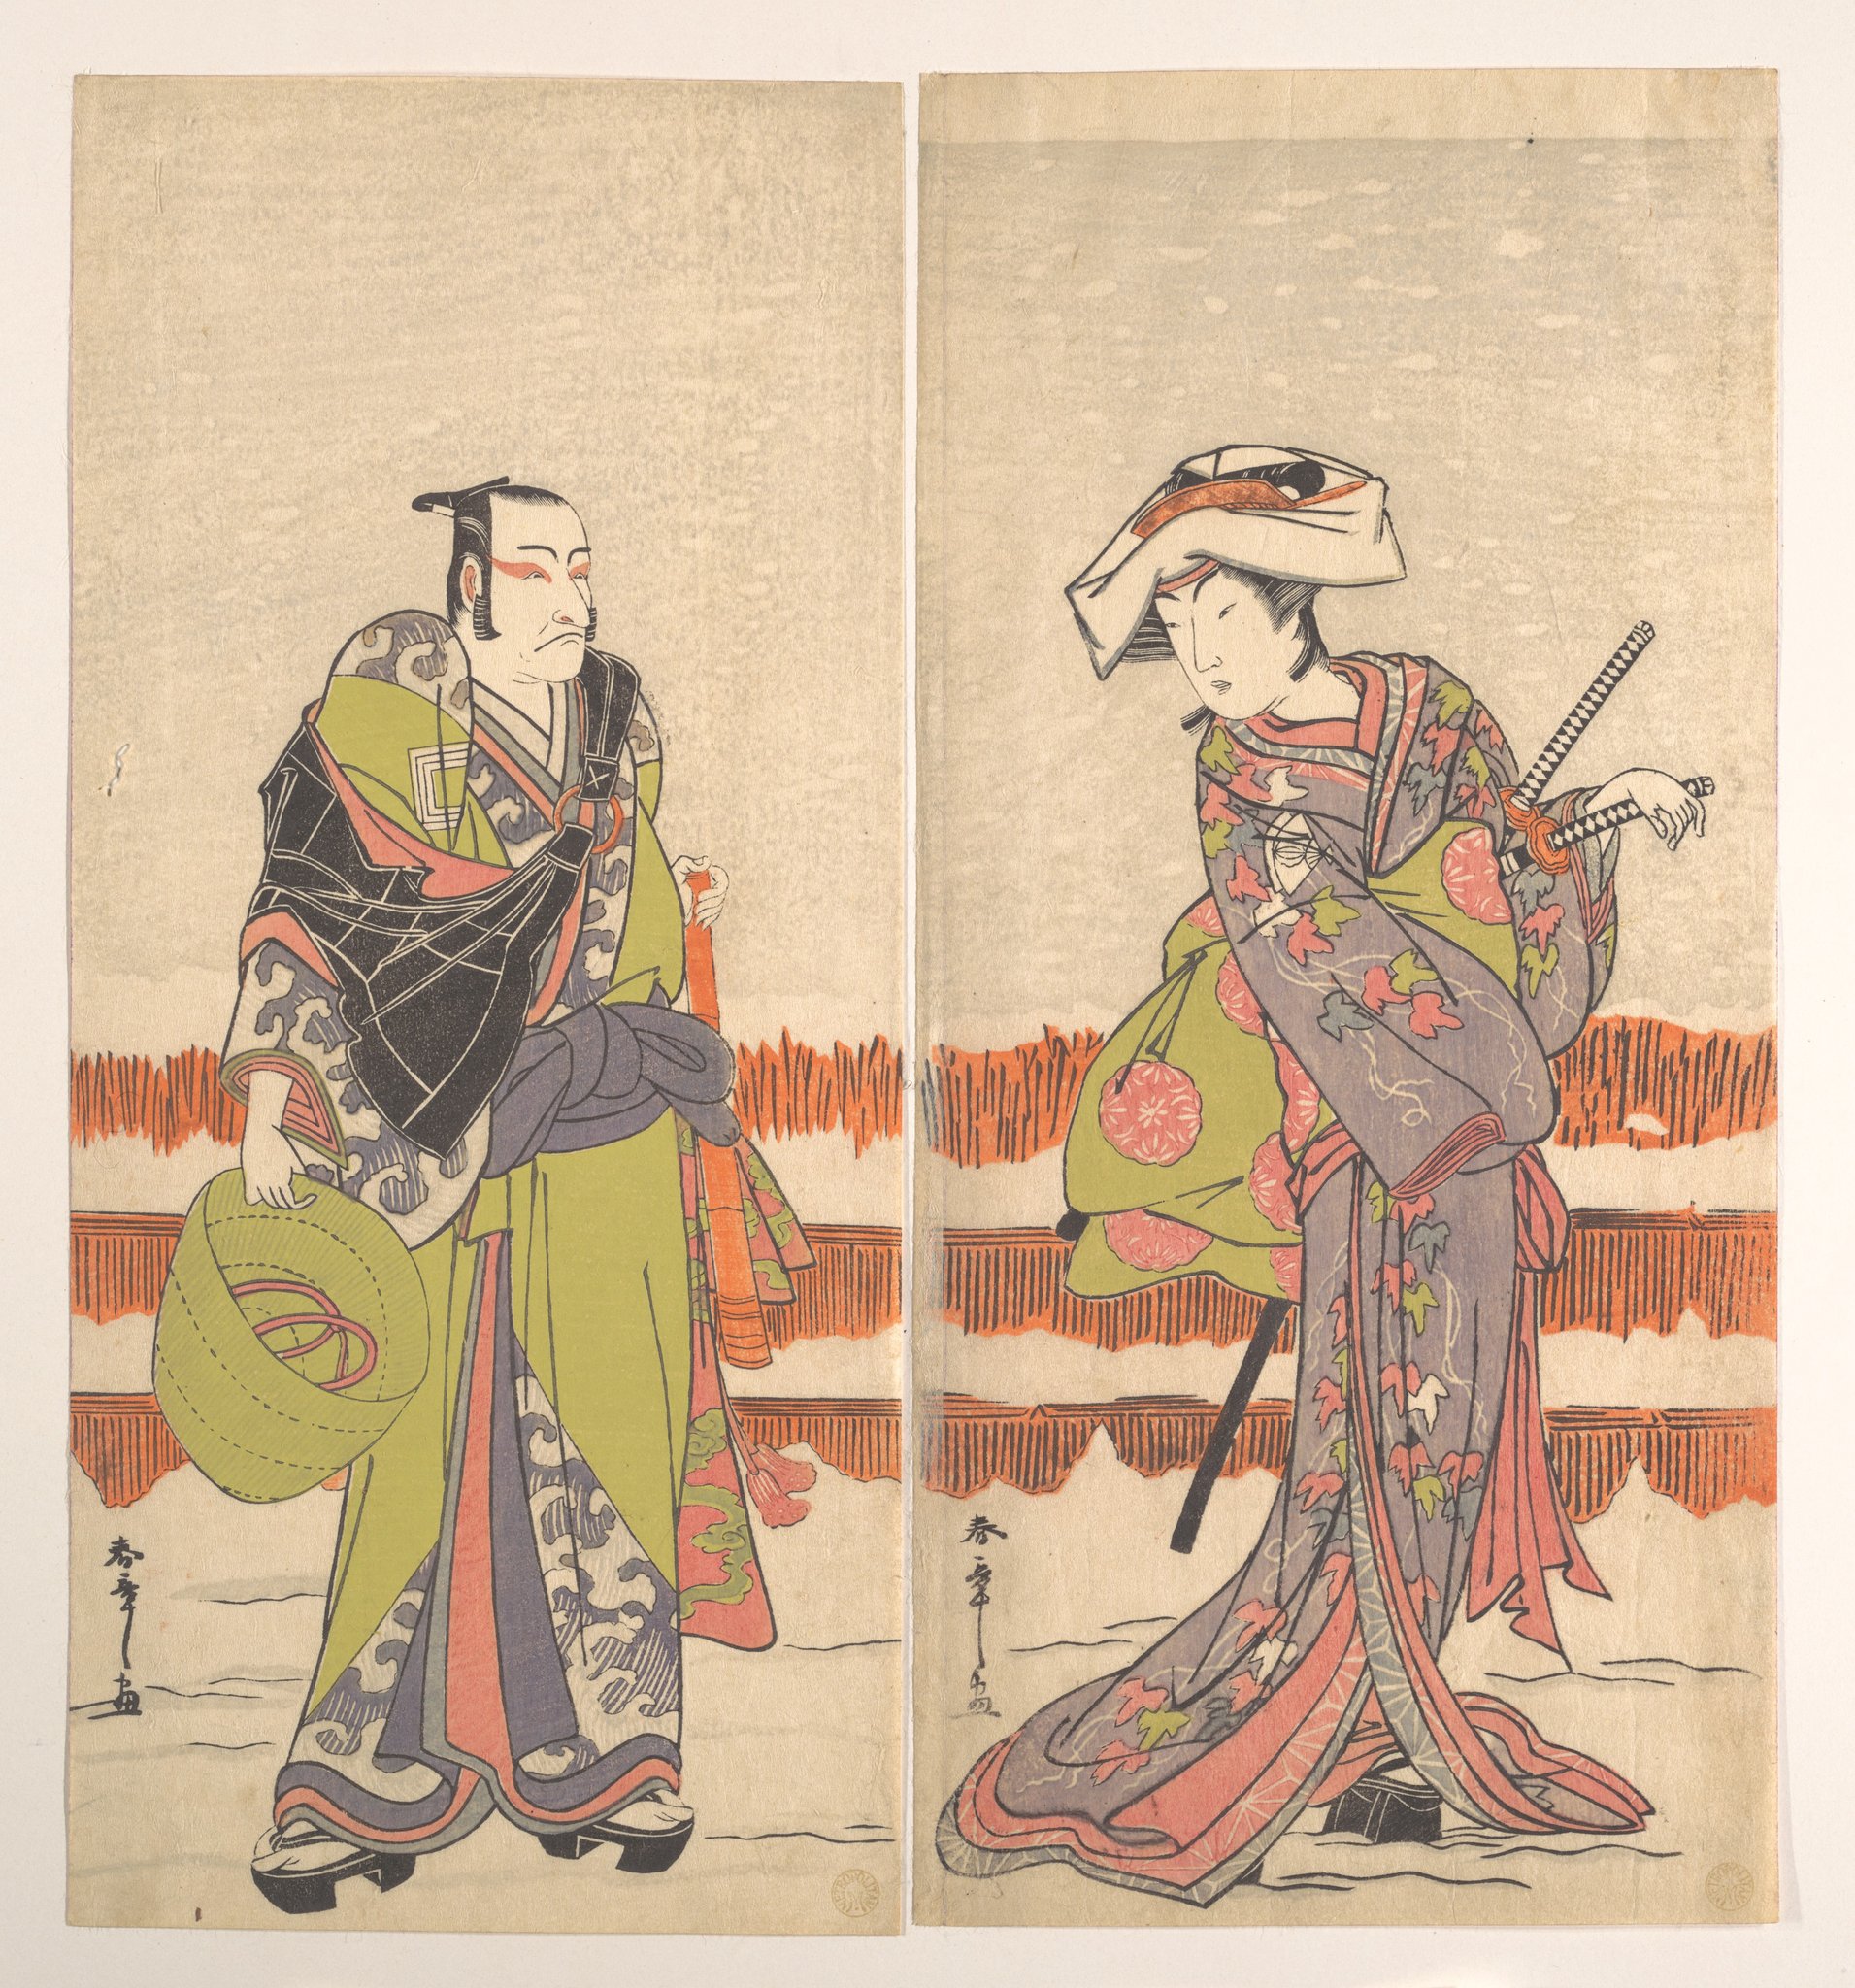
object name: woodblock print nishiki e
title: Ichikawa Danjuro Fifth as a Komuso Holding a Basket-Hat in His Right Hand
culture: japanese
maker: katsukawa shunshō 勝川春章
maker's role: artist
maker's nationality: japanese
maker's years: 1726-1792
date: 1775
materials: ink, paper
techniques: nishiki e, woodblock print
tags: hats,men,women,actors